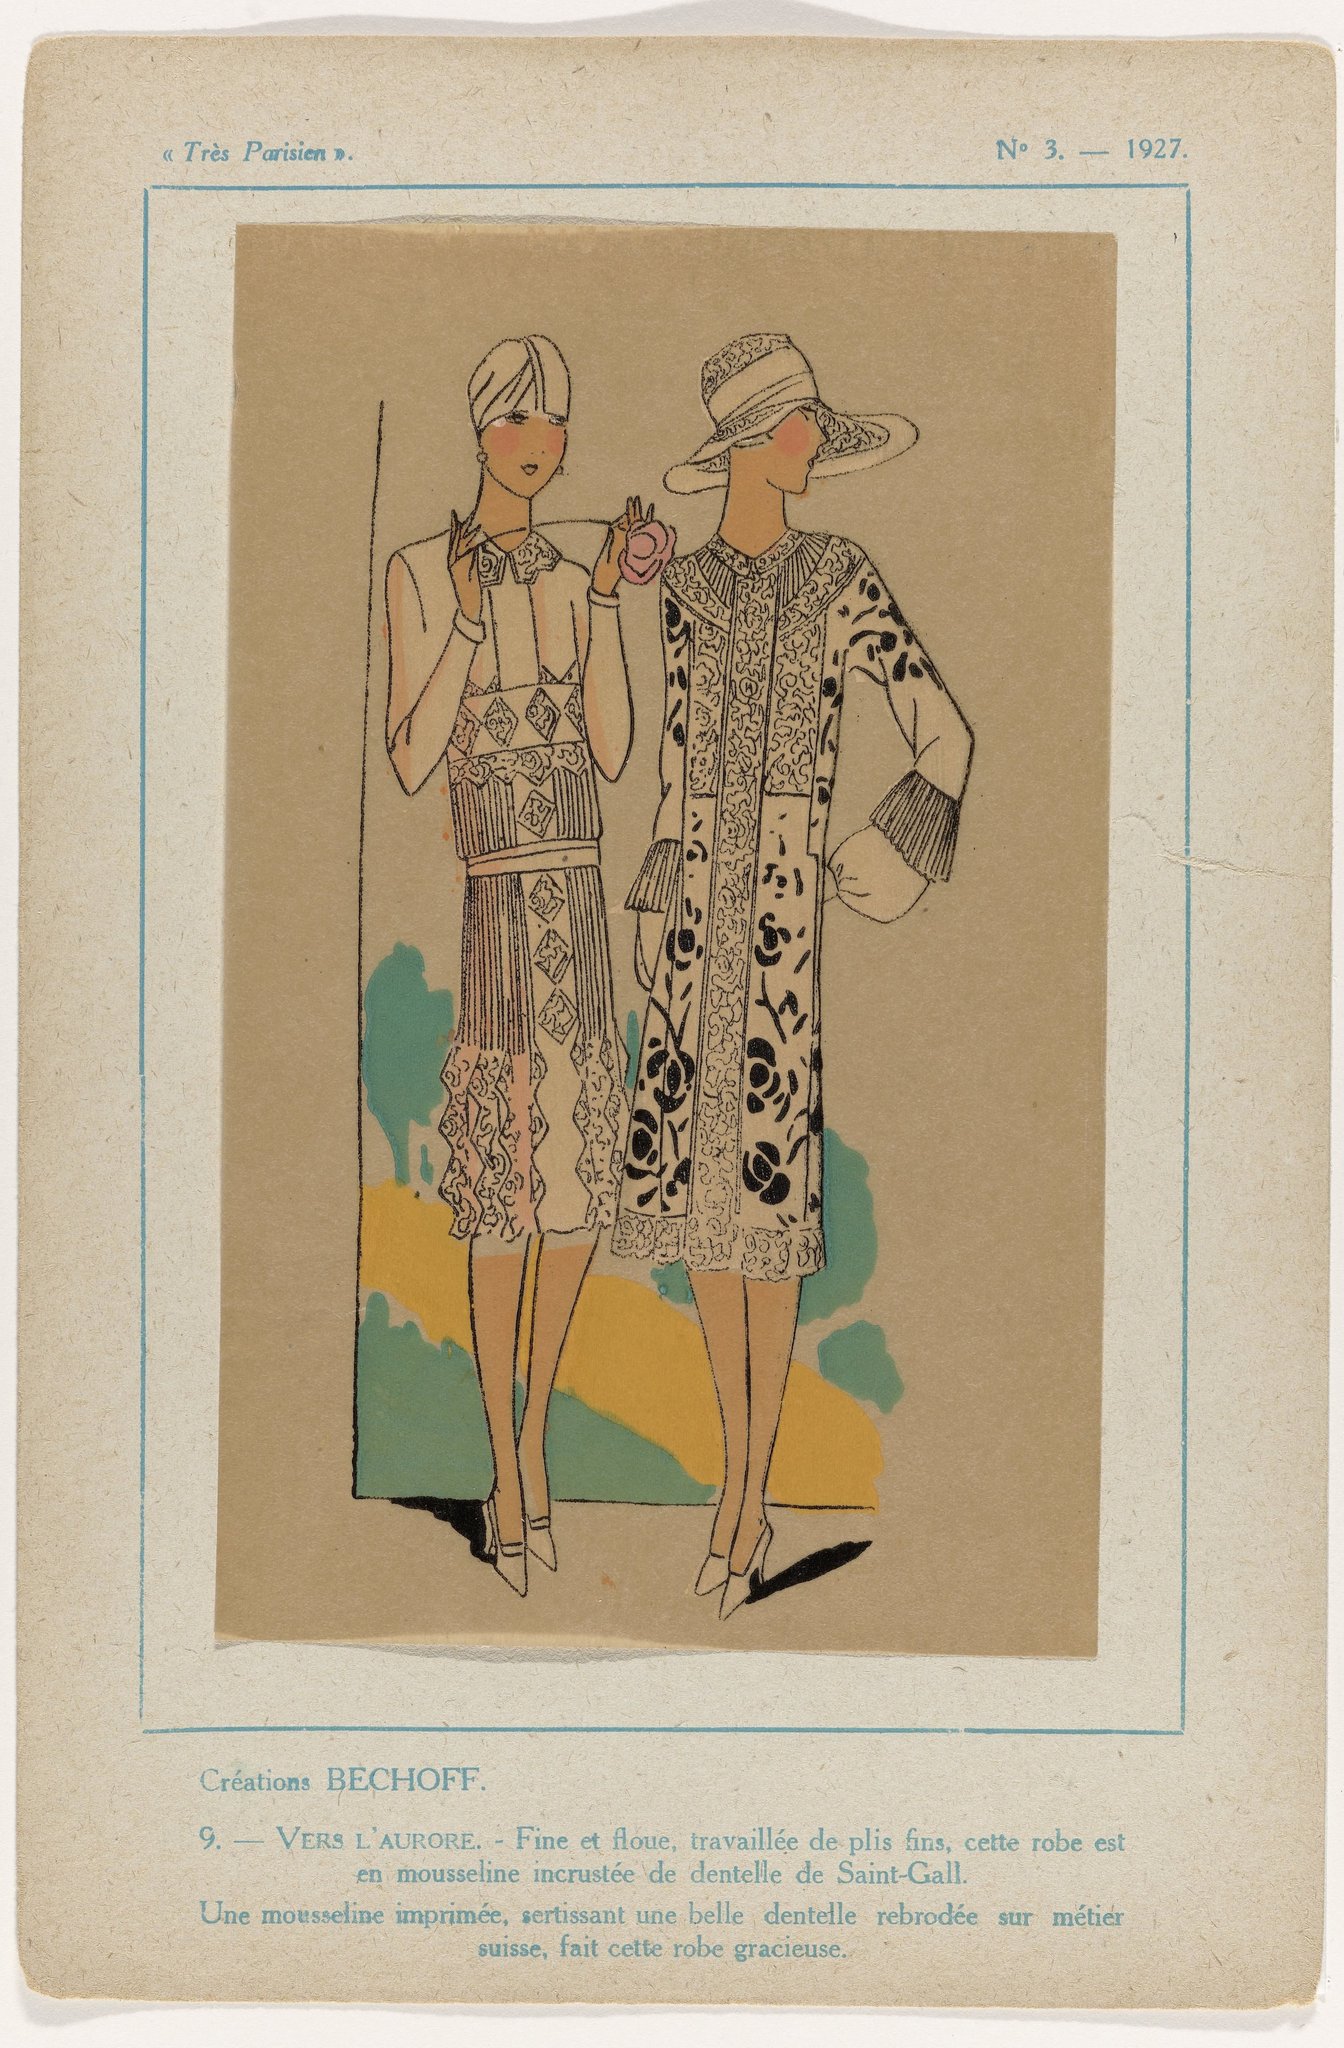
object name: fashion print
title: Très Parisien. La Mode, Le Chic, L’Elégance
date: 1927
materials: paper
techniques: hand coloring, letterpress printing, lithography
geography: paris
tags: cut flowers; nosegay, bunch of flowers, embroidery (ornamentation) (+ women's clothes), lace (+ women's clothes), fashion plates, head-gear: hat (+ women's clothes), dress, gown (+ women's clothes)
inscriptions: title: ‘"Très Parisien" / No 3. - 1927.’, caption: ‘Créations BECHOFF. / 9. - VERS L'AURORE. - Fine et floue, travaillée de plis fins, cette robe est en mousseline incrustée de dentelle de Saint-Gall. Une mousseline imprimée, sertissant une belle dentelle rebrodée sur métier suisse, fait cette robe gracieuse.’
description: Très Parisien promoted itself as chic and elegant. Between 1920 and 1936 it presented creations by such couturiers as Chéruit, Premet, Philip et Gaston, and Lanvin. The young, svelte models are all ultra-modern, shown talking on the phone, smoking and playing tennis. The illustrations also show that over the course of the 1920s, skirt lengths had risen to just below the knee, before dropping back down to calf length in the 1930s. The small plates were printed on transparent paper using a stencilling technique known as en pochoir and then hand coloured; many of them are unsigned. The signature ‘Joujou’ belonged to Germaine Paule Joumard, who was the director of Très Parisien, as well as one of the magazine’s illustrators.